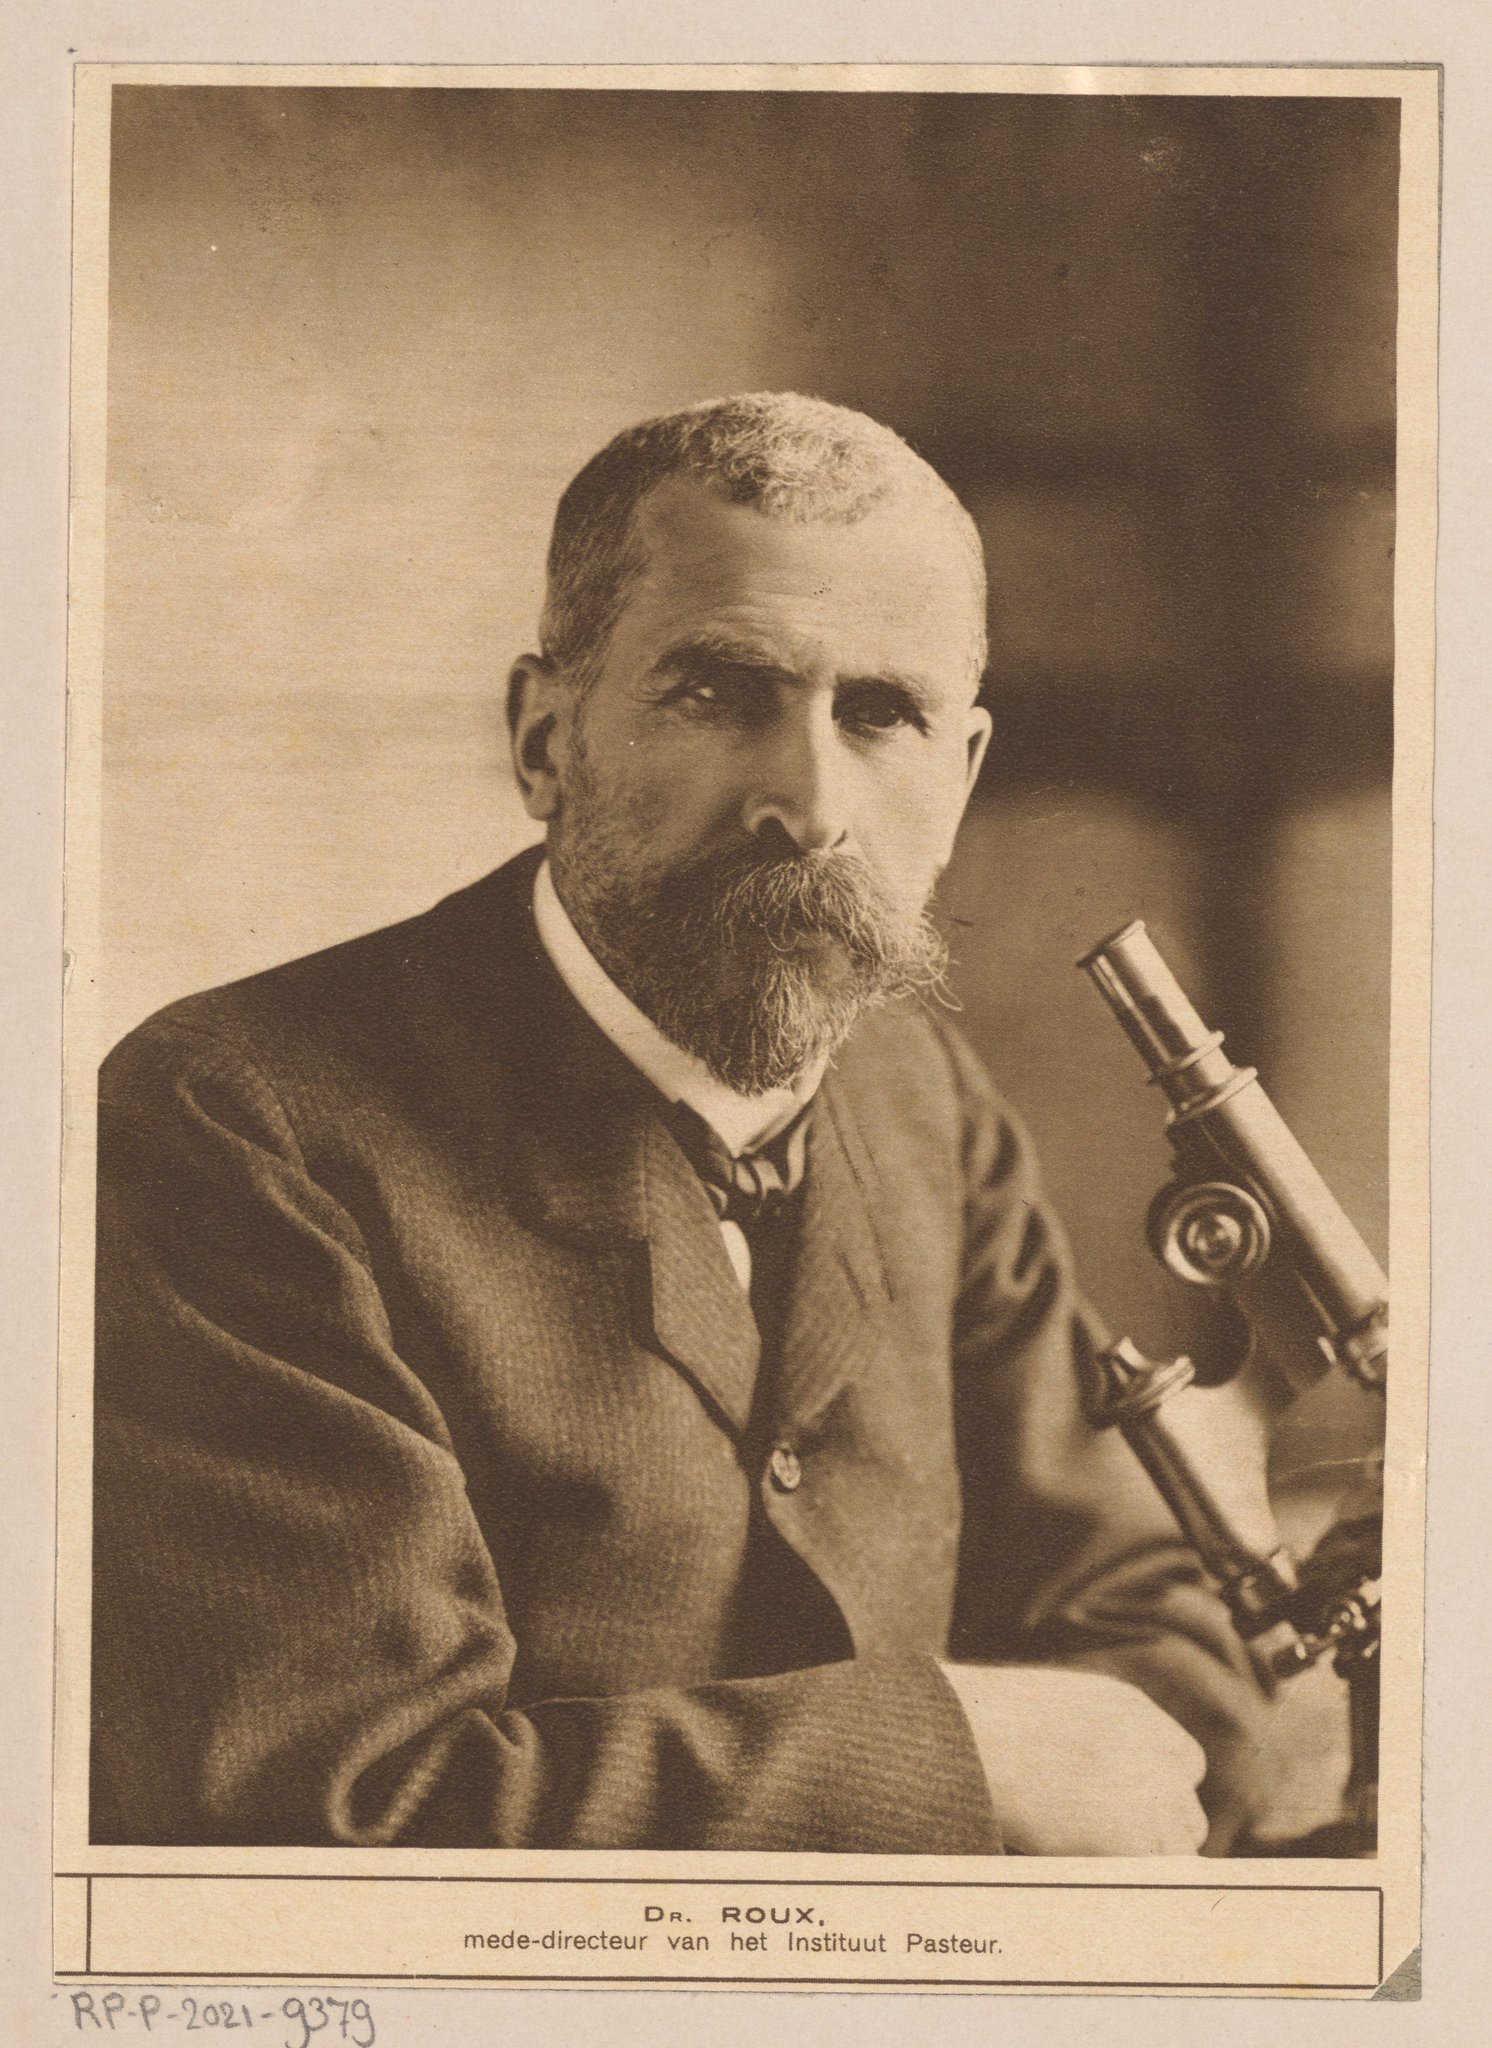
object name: photomechanical print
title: Portret van Émile Roux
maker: Anonymous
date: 1895-1939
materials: paper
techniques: rotogravure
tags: paris, historical persons